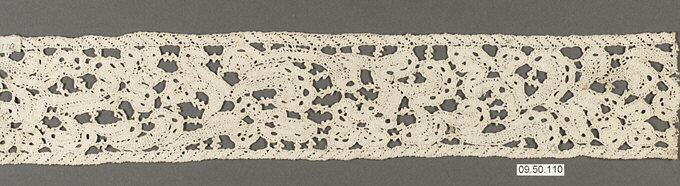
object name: strip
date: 1701-1800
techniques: lace